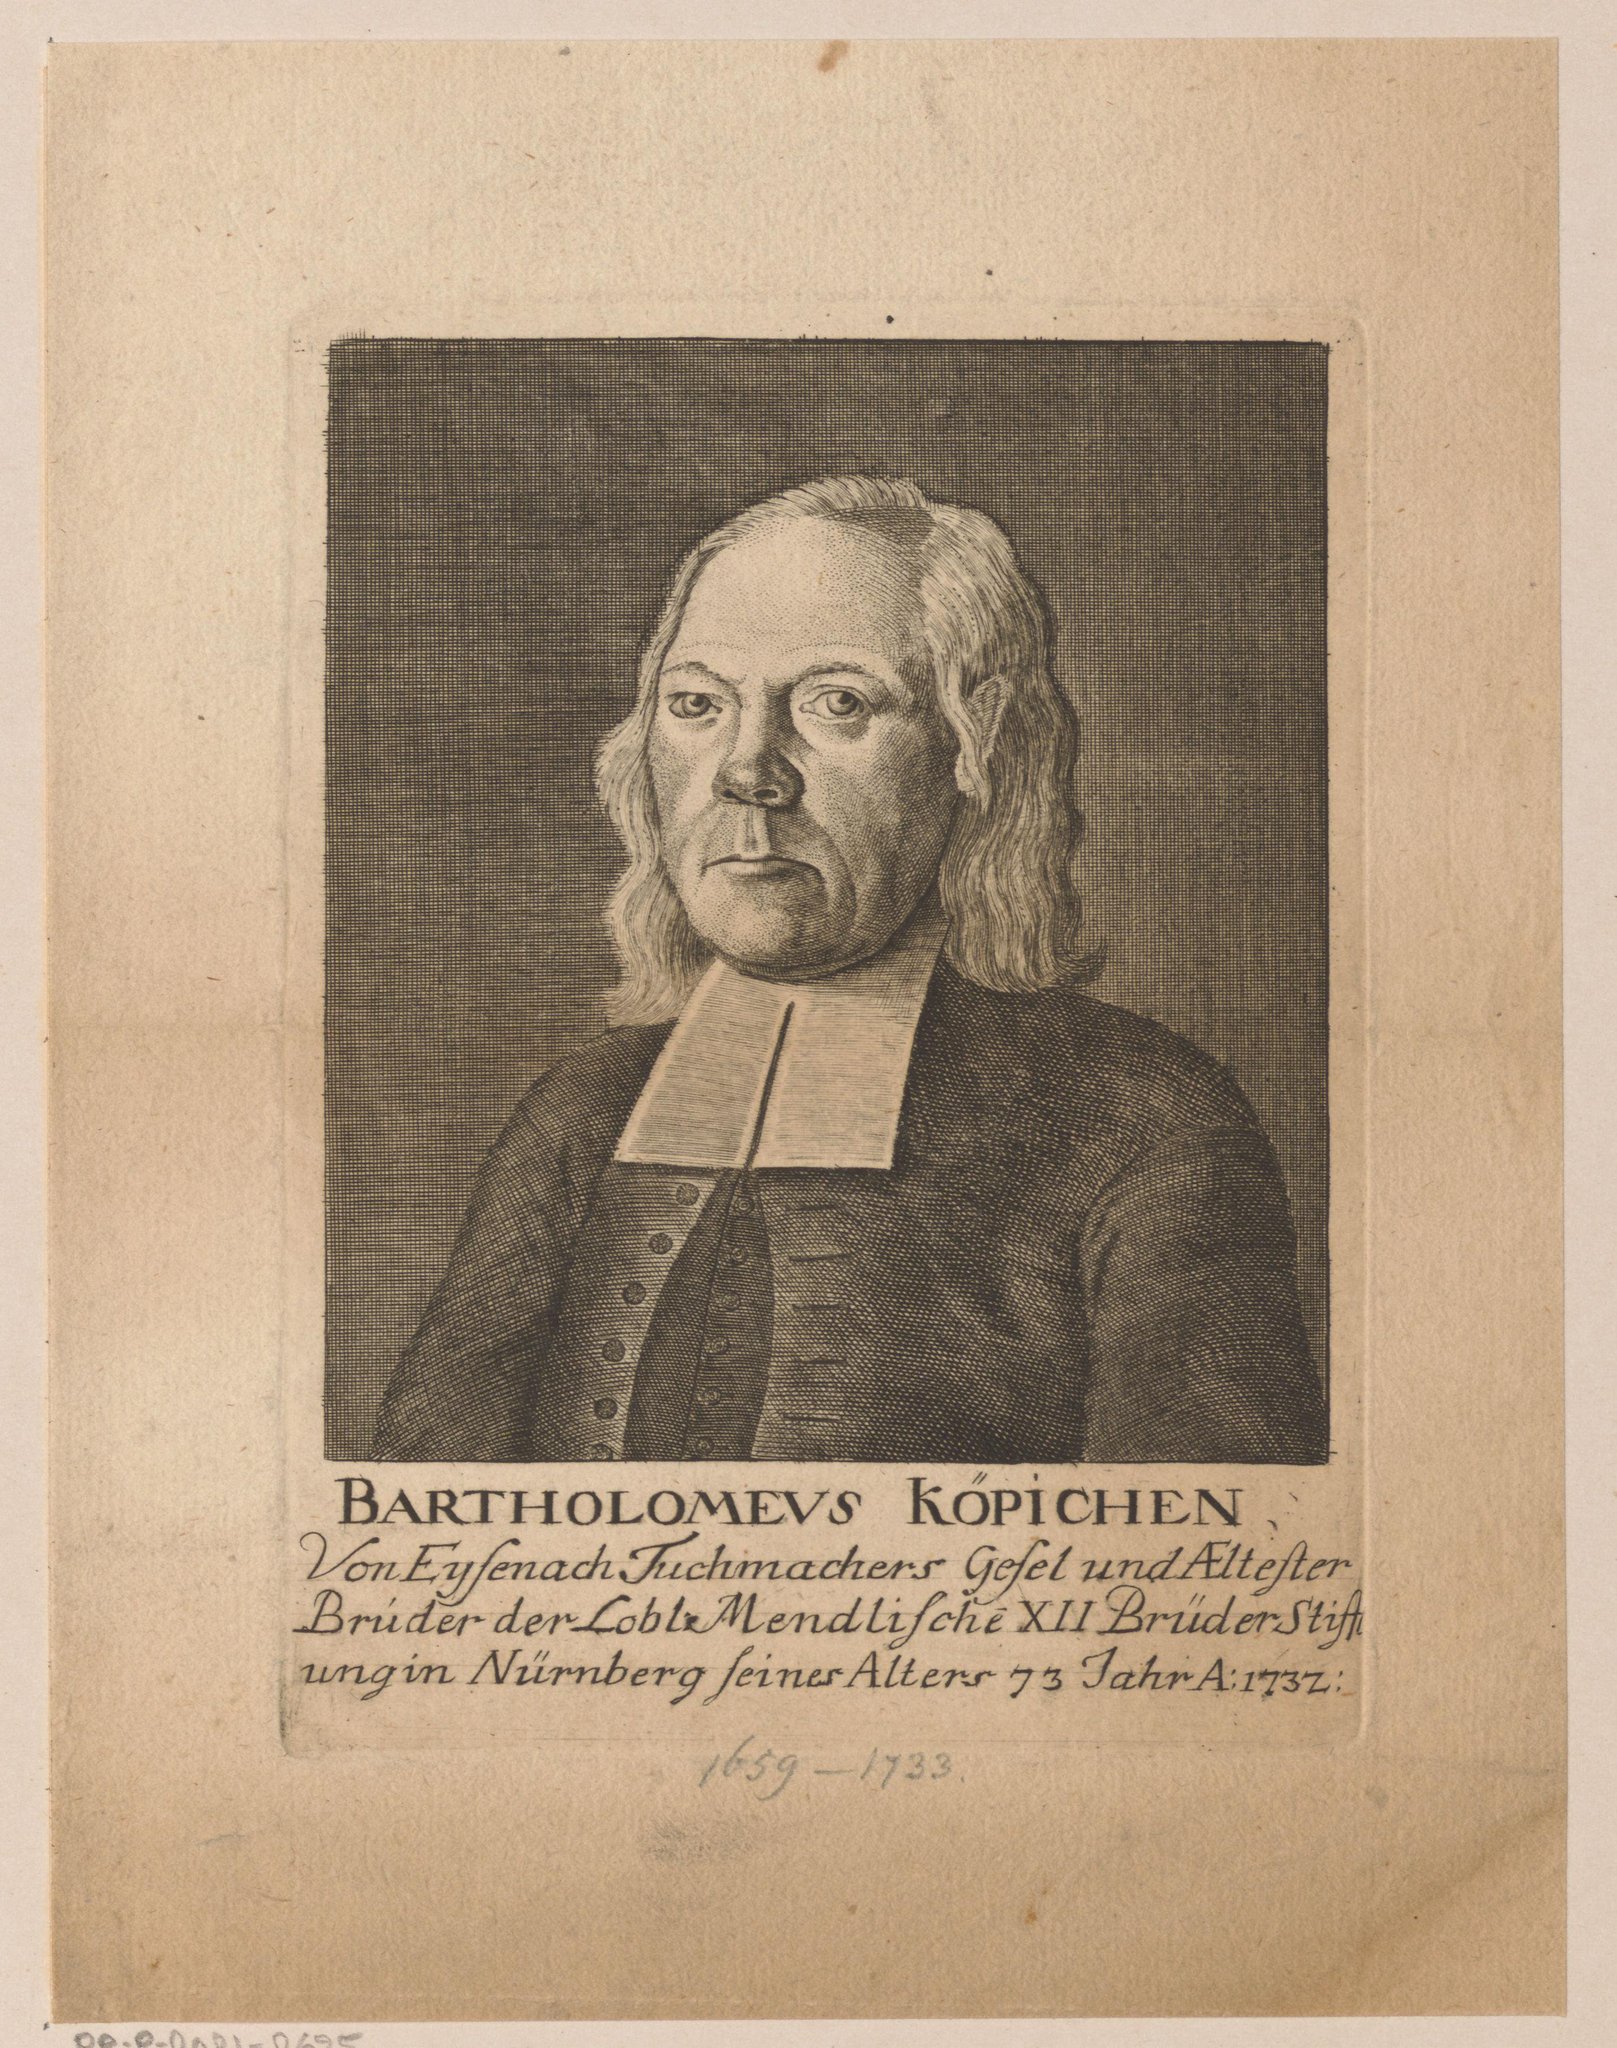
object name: print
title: Portret van Bartholomäus Köpichen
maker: Anonymous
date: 1689-1749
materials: paper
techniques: engraving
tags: historical persons